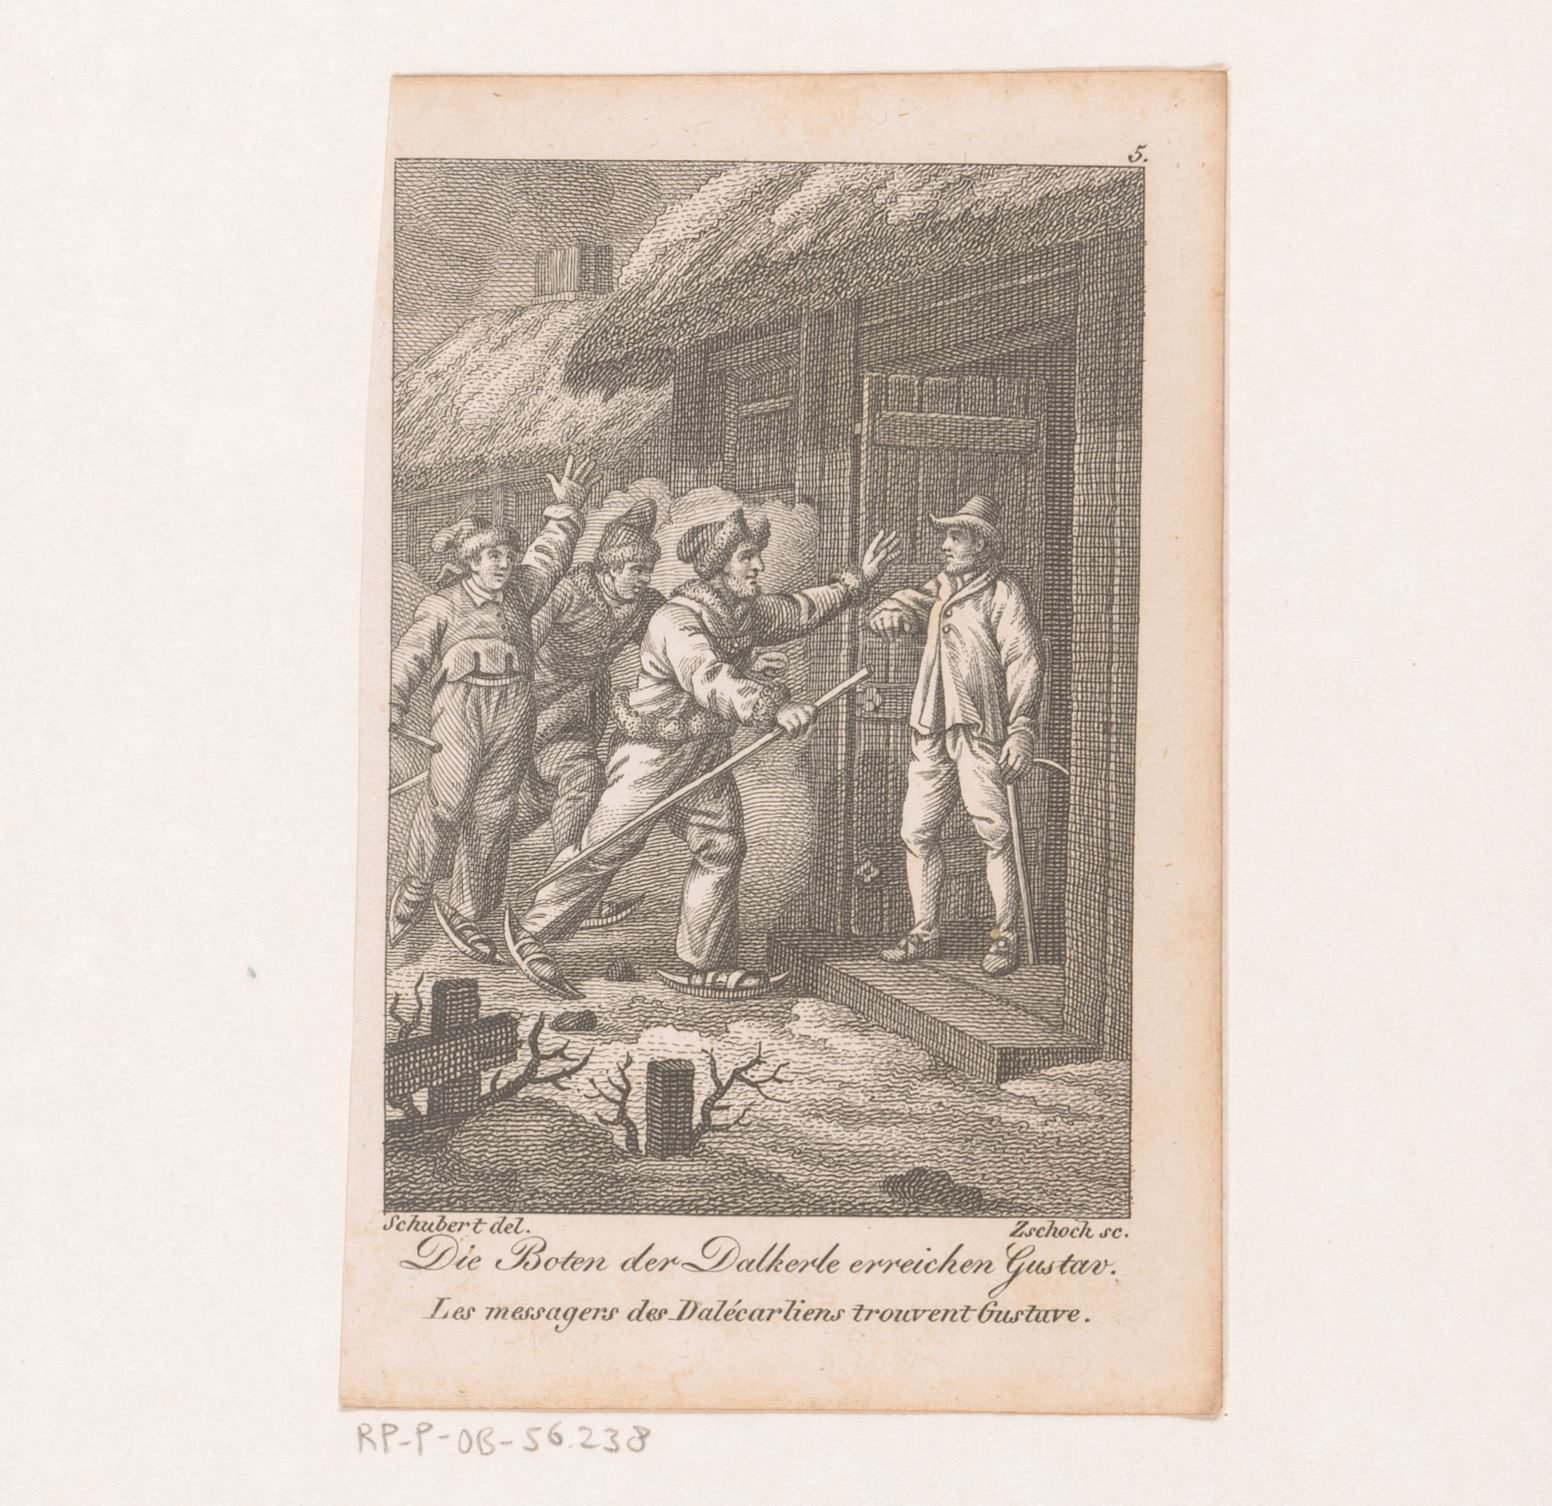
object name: print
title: Dalecarliërs vinden Gustav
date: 1785-1833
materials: paper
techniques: etching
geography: germany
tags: open door, snow-shoes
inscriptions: collector's mark: Lugt 2228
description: Deze prent maakt deel uit van een serie van onbekende omvang met scènes uit de geschiedenis van Zweden.